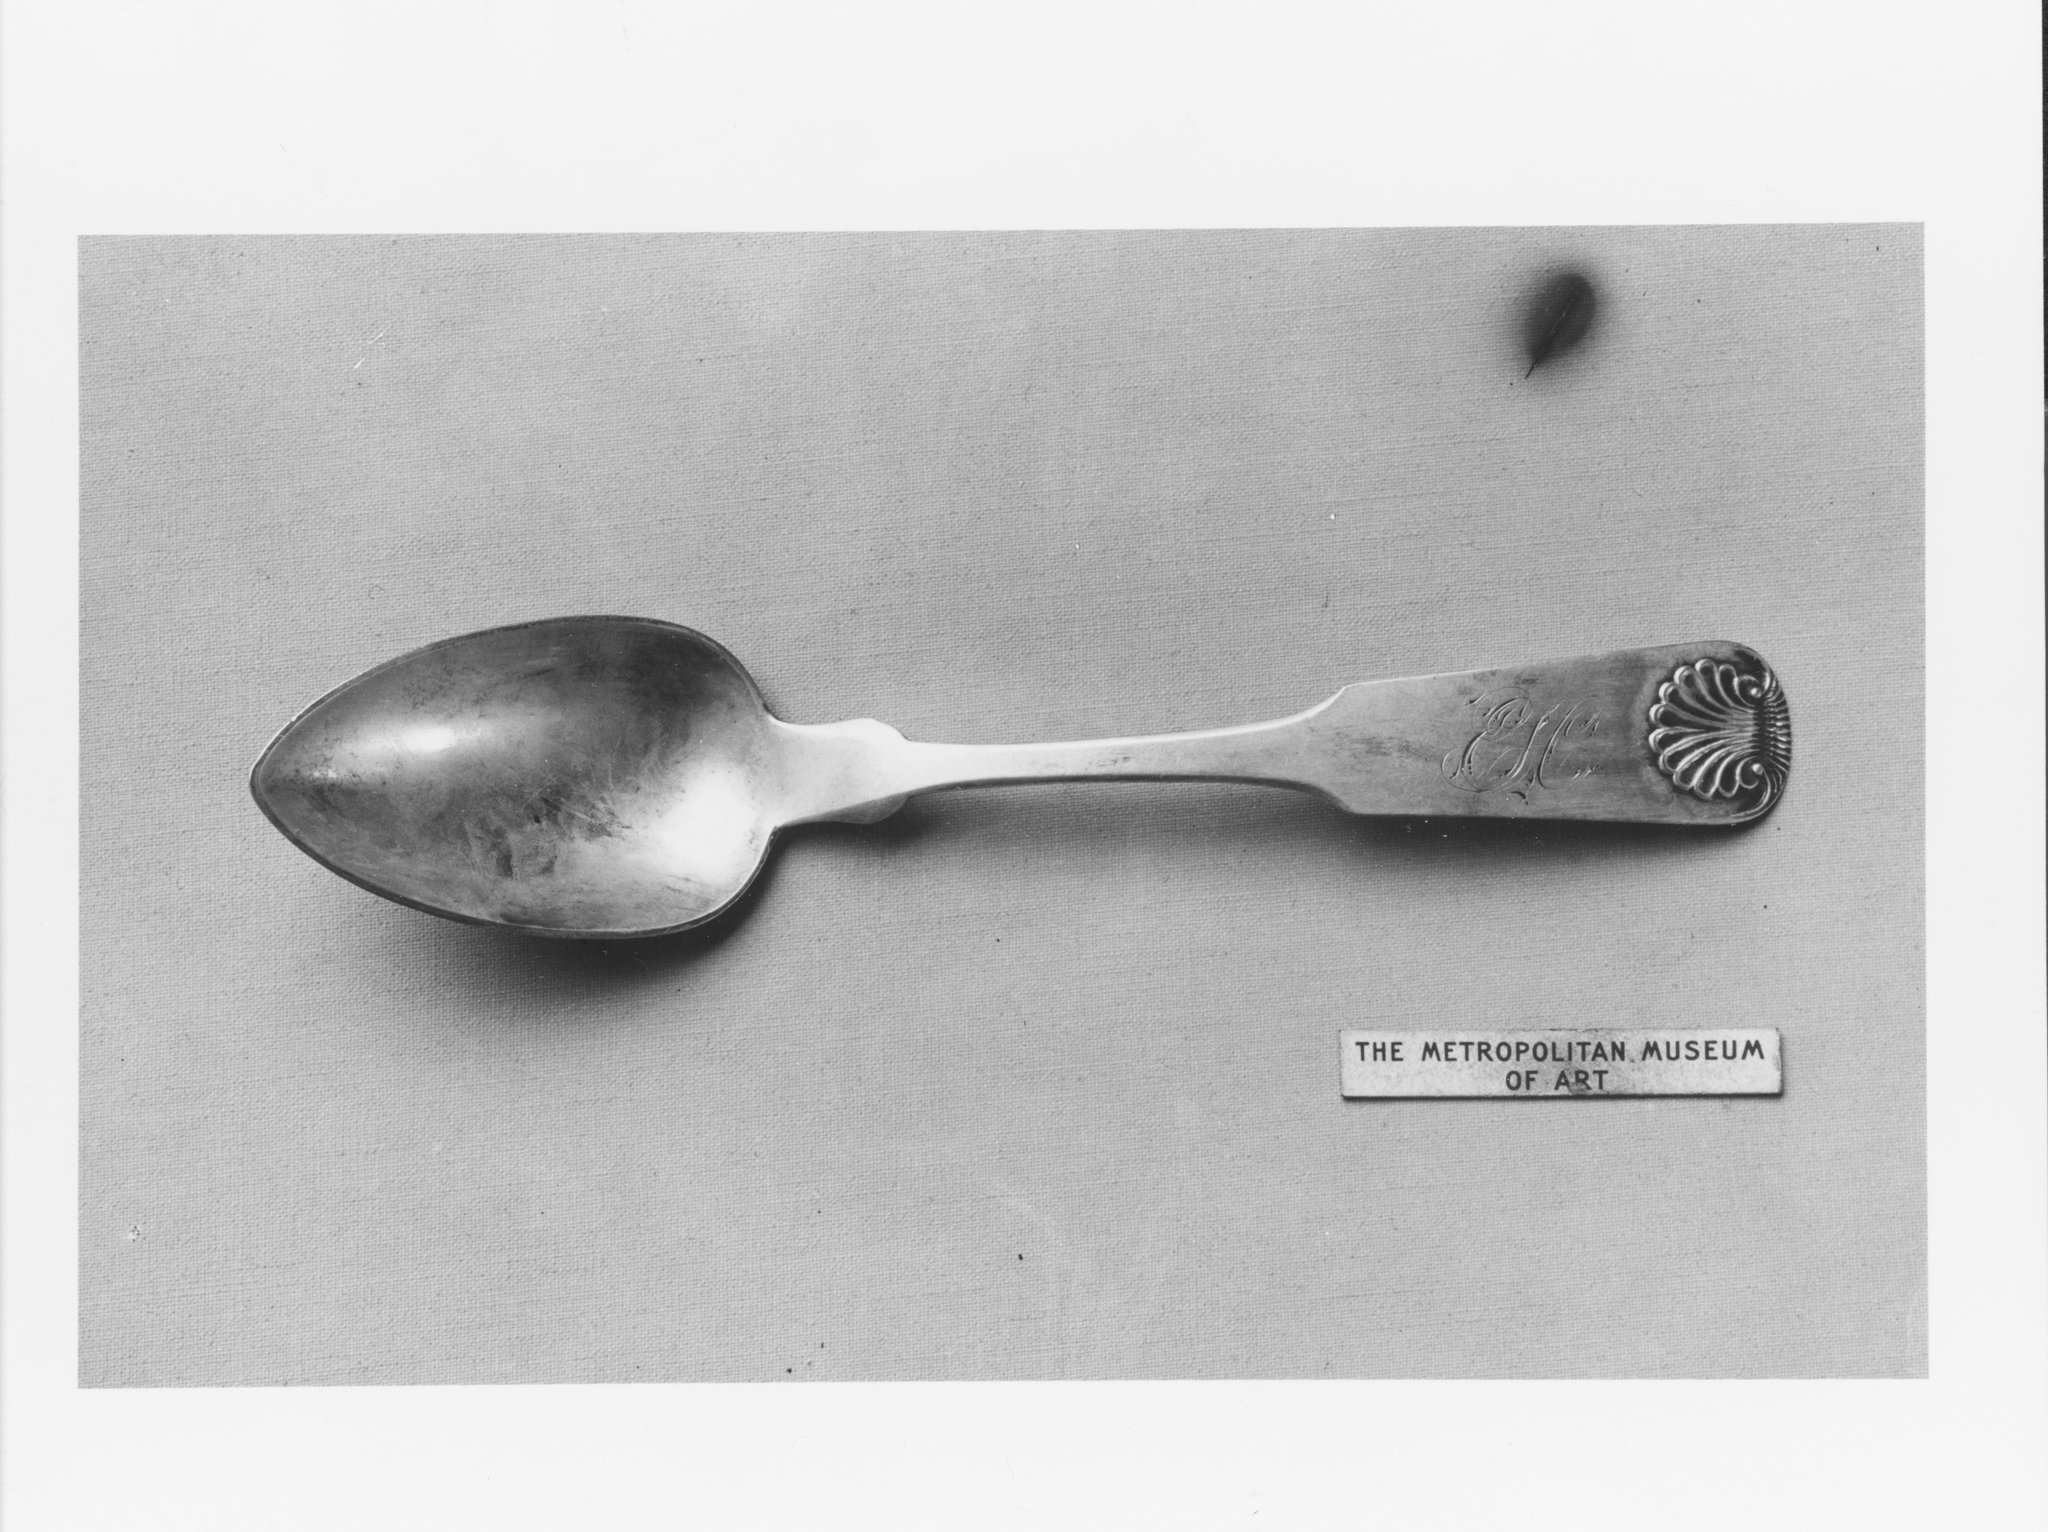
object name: spoon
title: Dessert Spoon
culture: american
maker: martin benedict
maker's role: maker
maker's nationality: american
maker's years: 1823-1847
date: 1800-1830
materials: silver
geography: united states